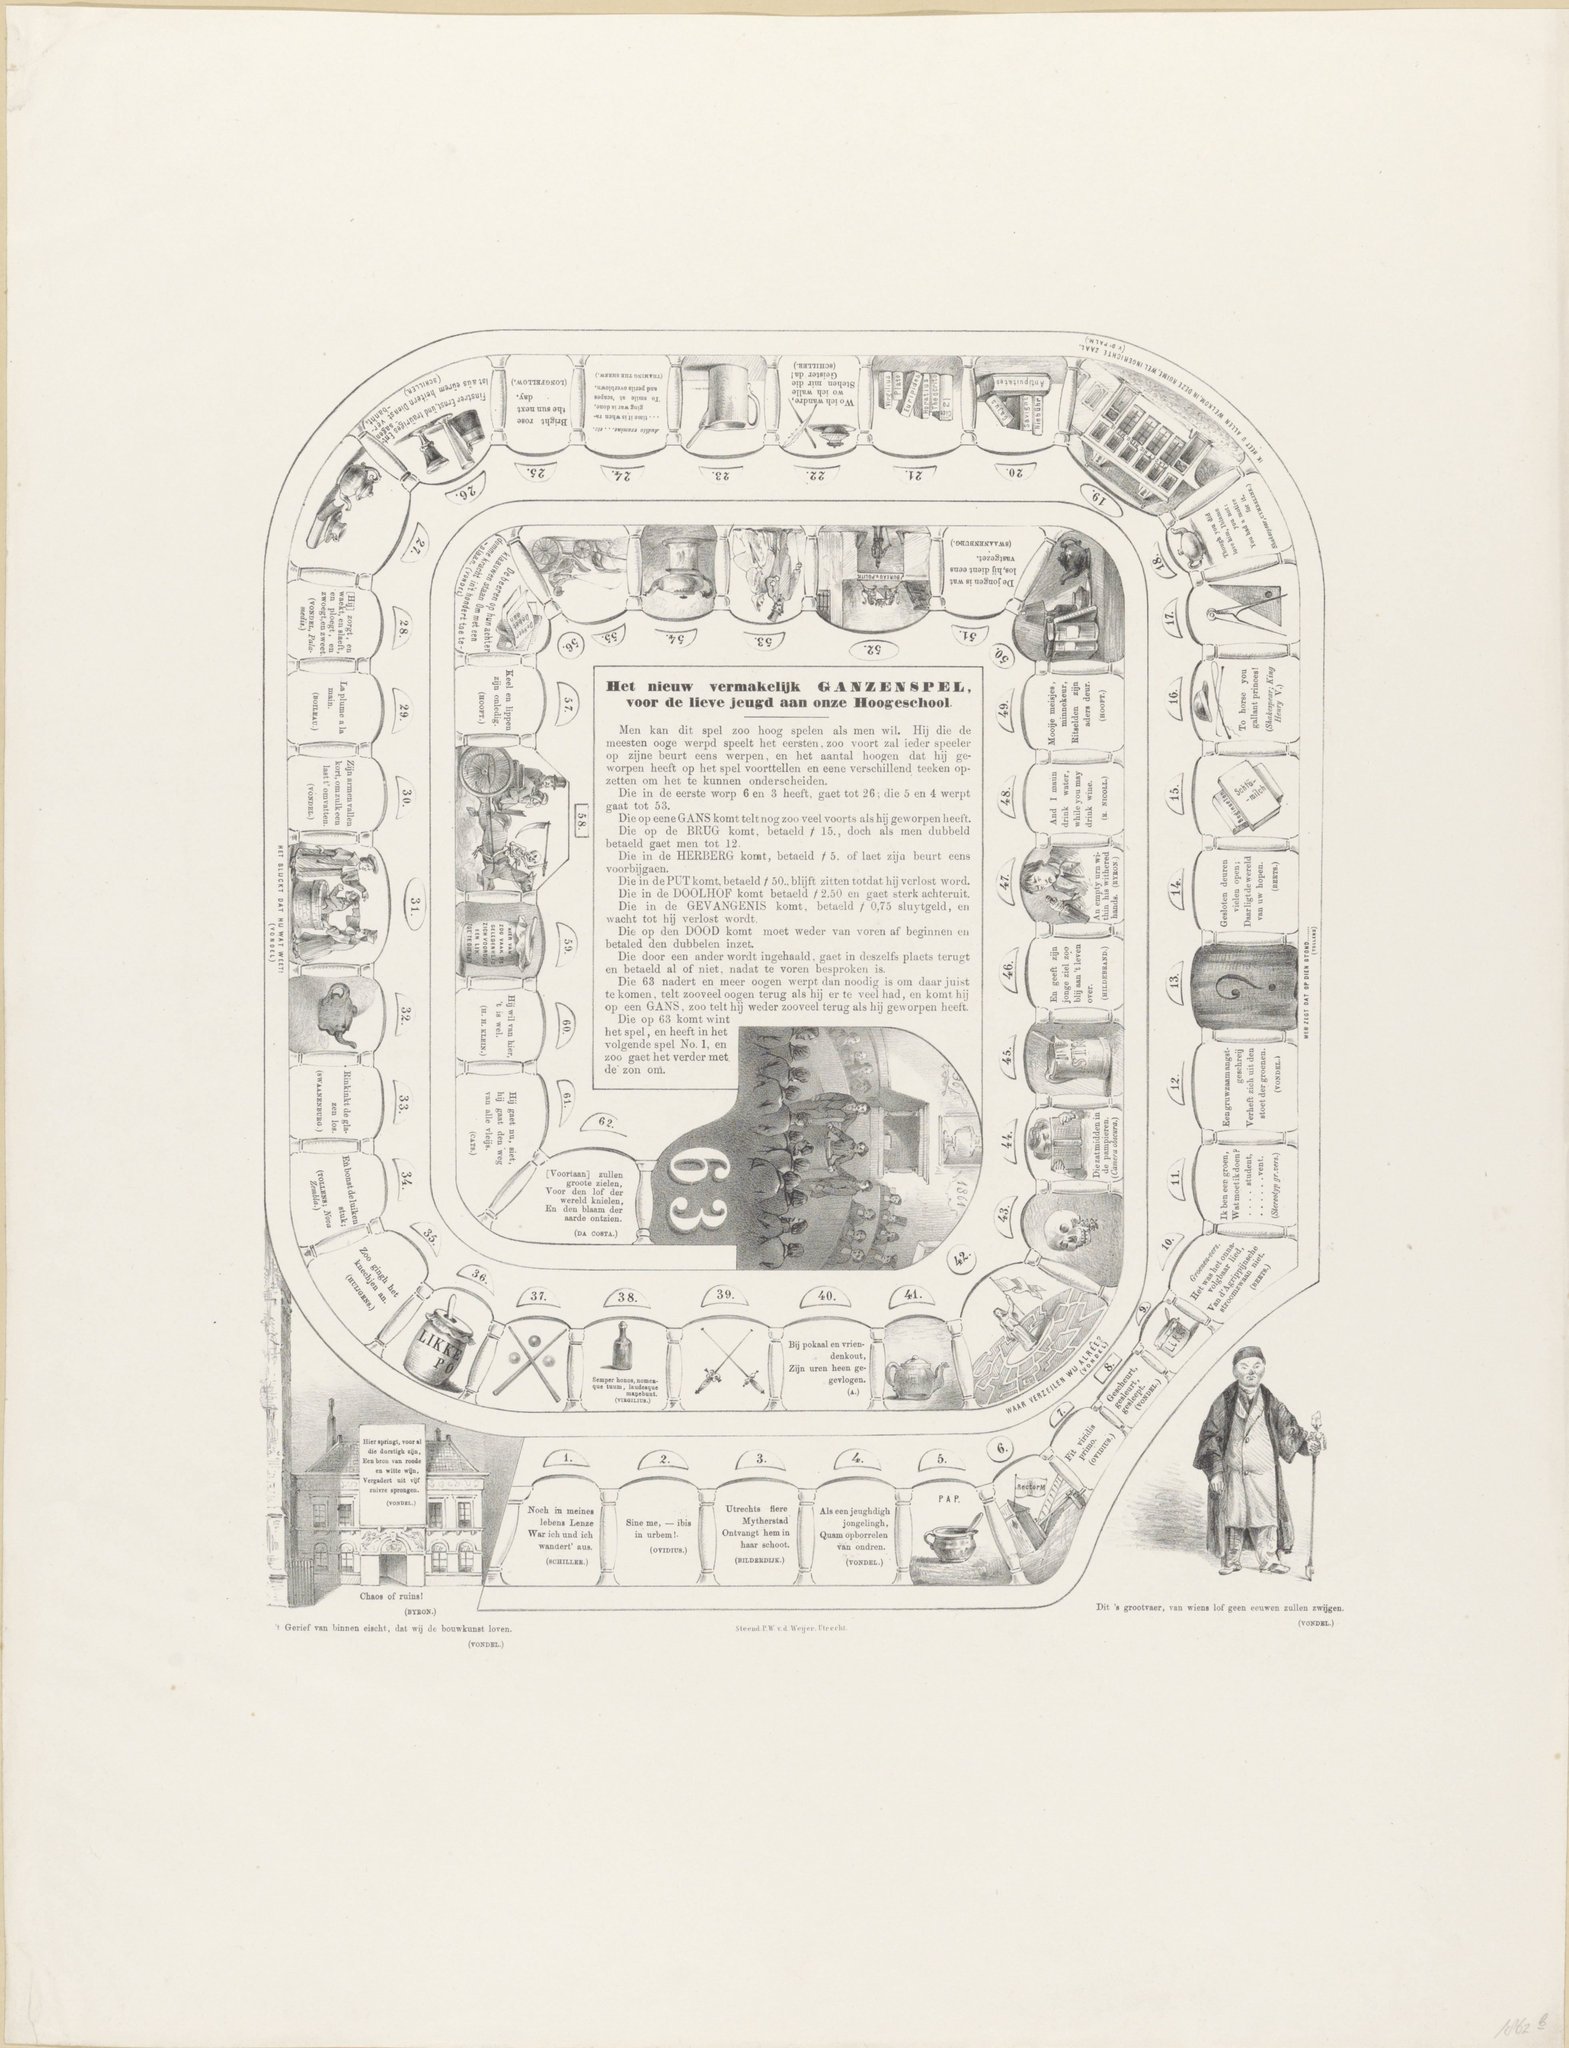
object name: cartoon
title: Een nieuw vermakelijk Ganzenspel, voor de lieve jeugd aan onze Hoogeschool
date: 1864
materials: paper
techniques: lithograph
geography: utrecht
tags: goose-game, beadle, students' organization, utrecht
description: Spotprent over de Utrechtse Hogeschool in de vorm van een ganzenbordspel. In het middel de spelregels. Rechtsonder een portret van de Utrechtse pedel en boekverkoper J. de Kruyff. Plaat uit de studentenalmanak van de Utrechtse Hogeschool van 1864.